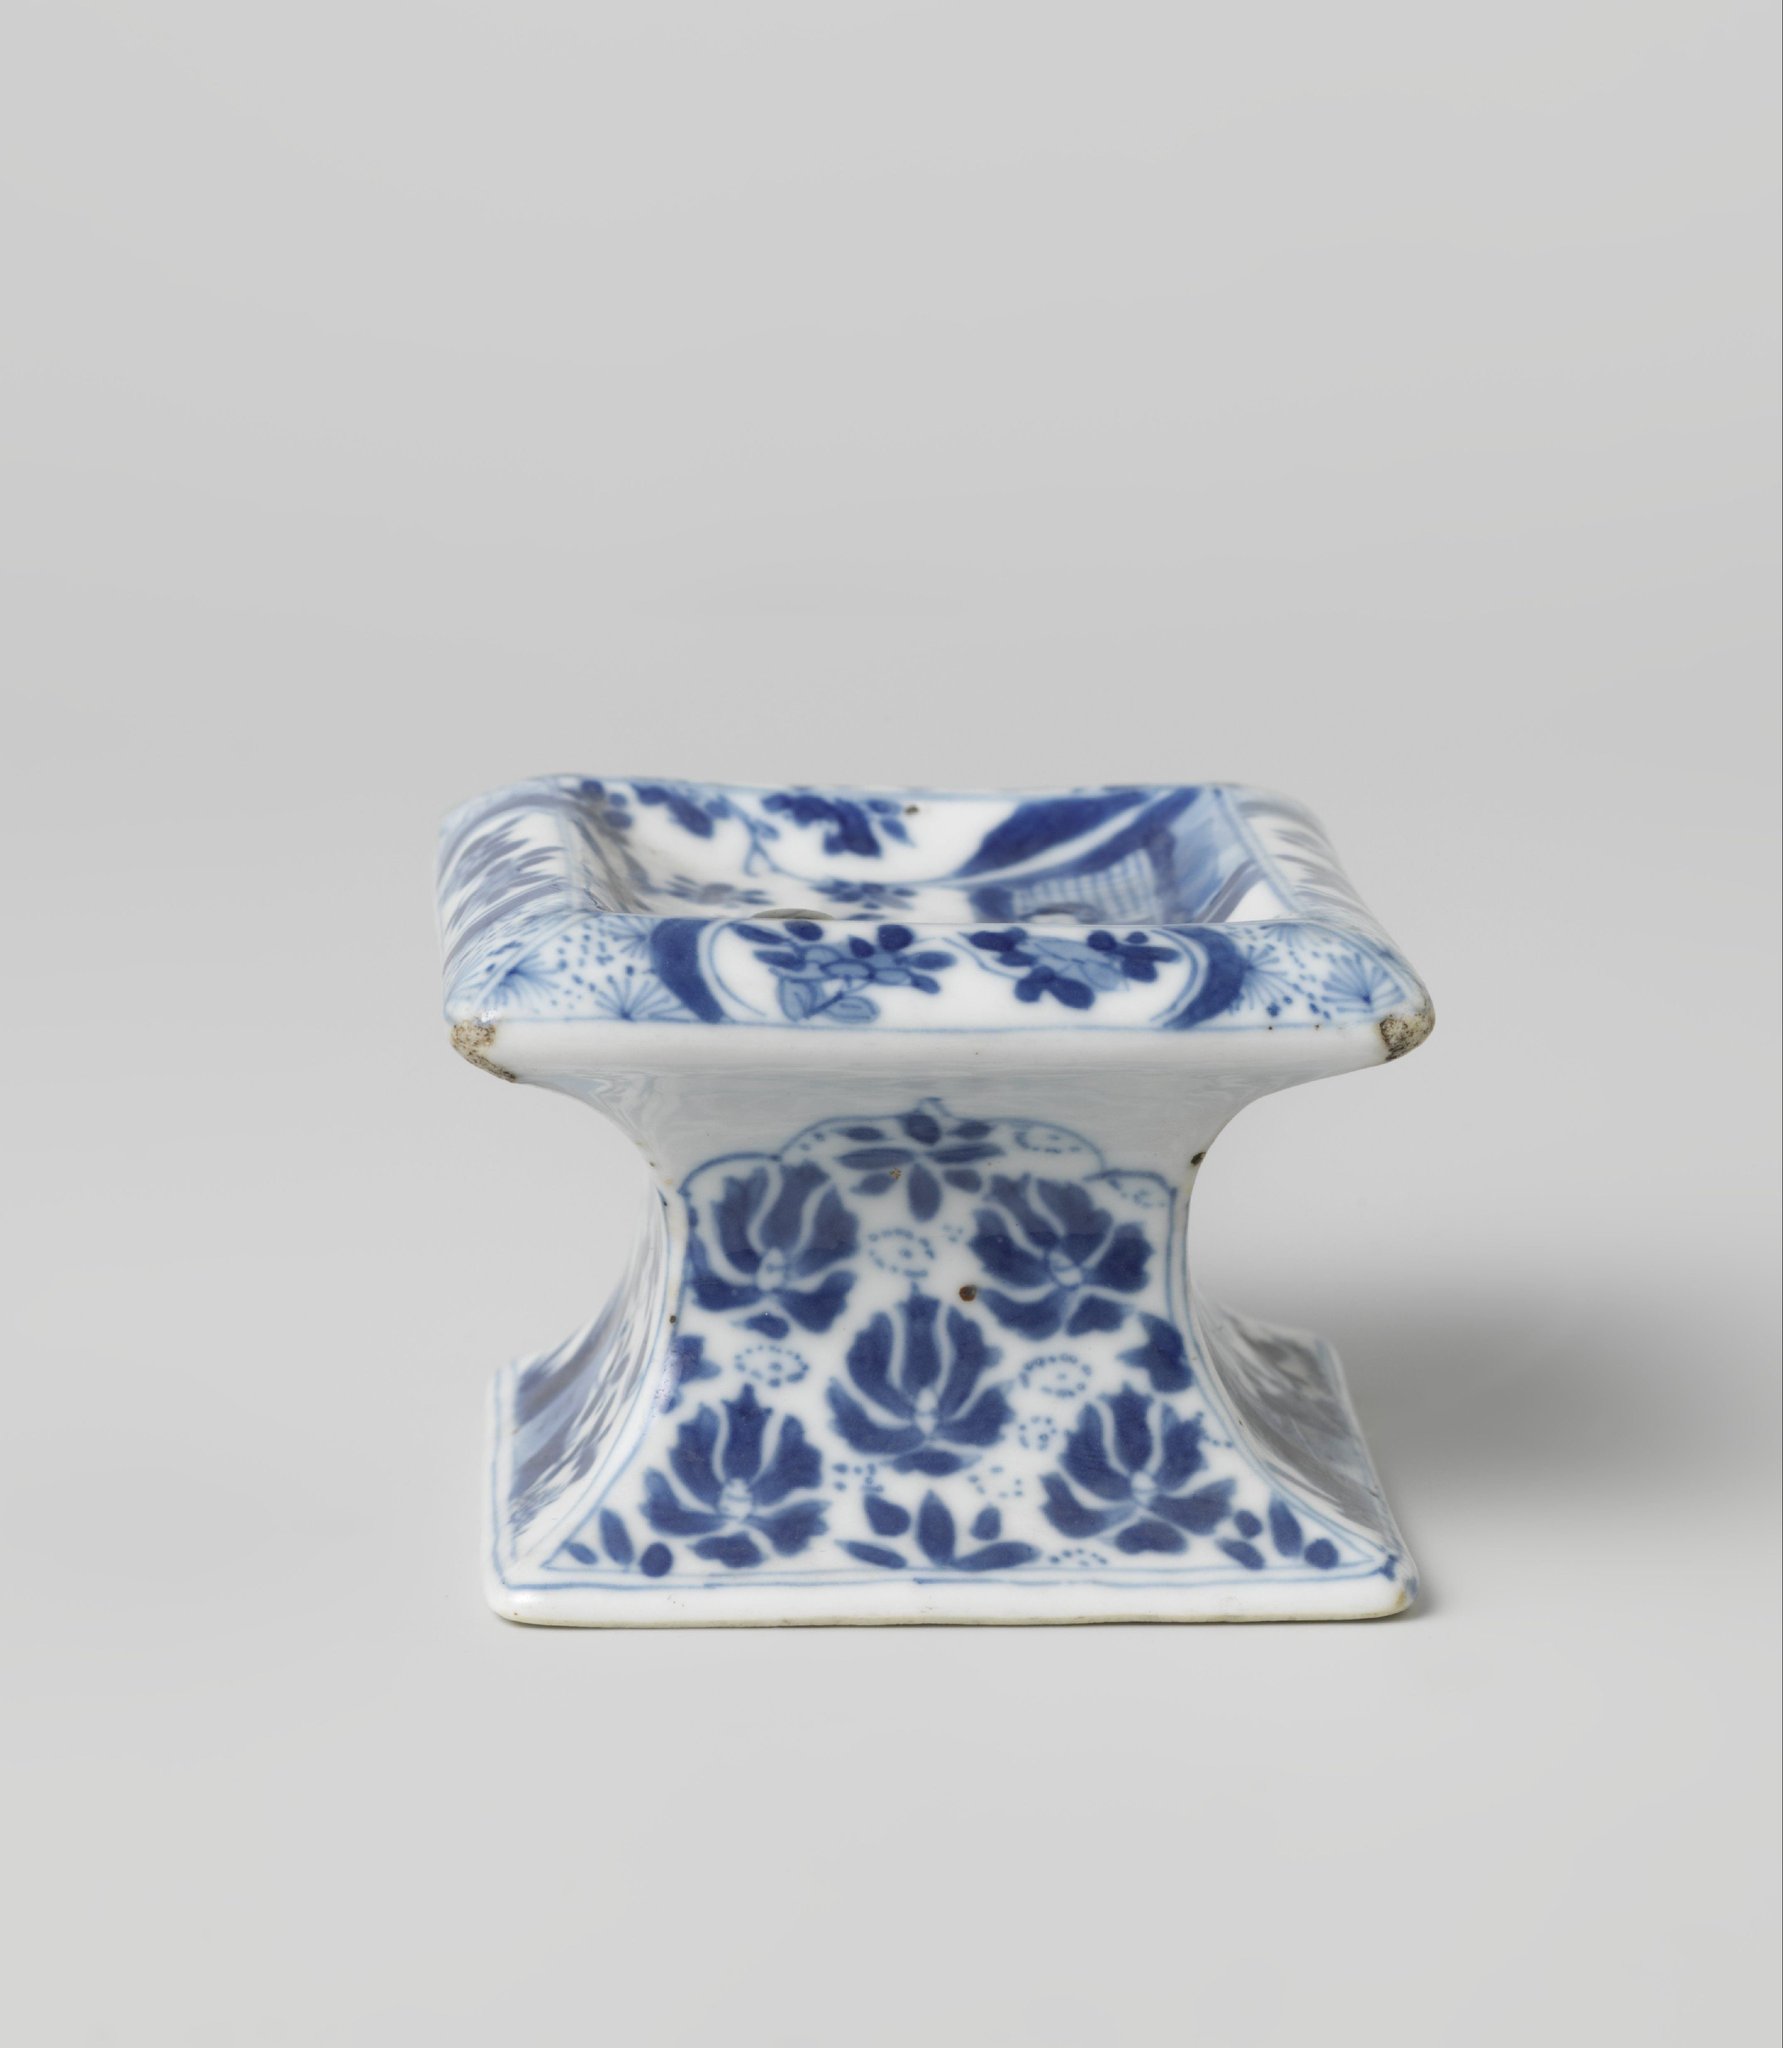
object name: salt condiment vessel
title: Square salt cellar with a woman and boy, floral scrolls and flowering plants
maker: Anonymous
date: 1700-1724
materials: cobalt, glaze, paint, porcelain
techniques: firing, forming, vitrification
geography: china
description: Vierkant zoutvat van porselein op een hoge, spreidende voet, beschilderd in onderglazuur blauw. Op de bovenzijde een vrouw (lange lijs) en jongen (zotje) in een omheinde tuin bij een paviljoen. Hieromheen een decoratieve band met bloemtakken in cartouches. Op de voet vier geschulpte vakken met afwisselend een bloeiende plant bij een rots en bloemranken. Het glazuur is op de hoeken afgebroken. Blauw-wit.